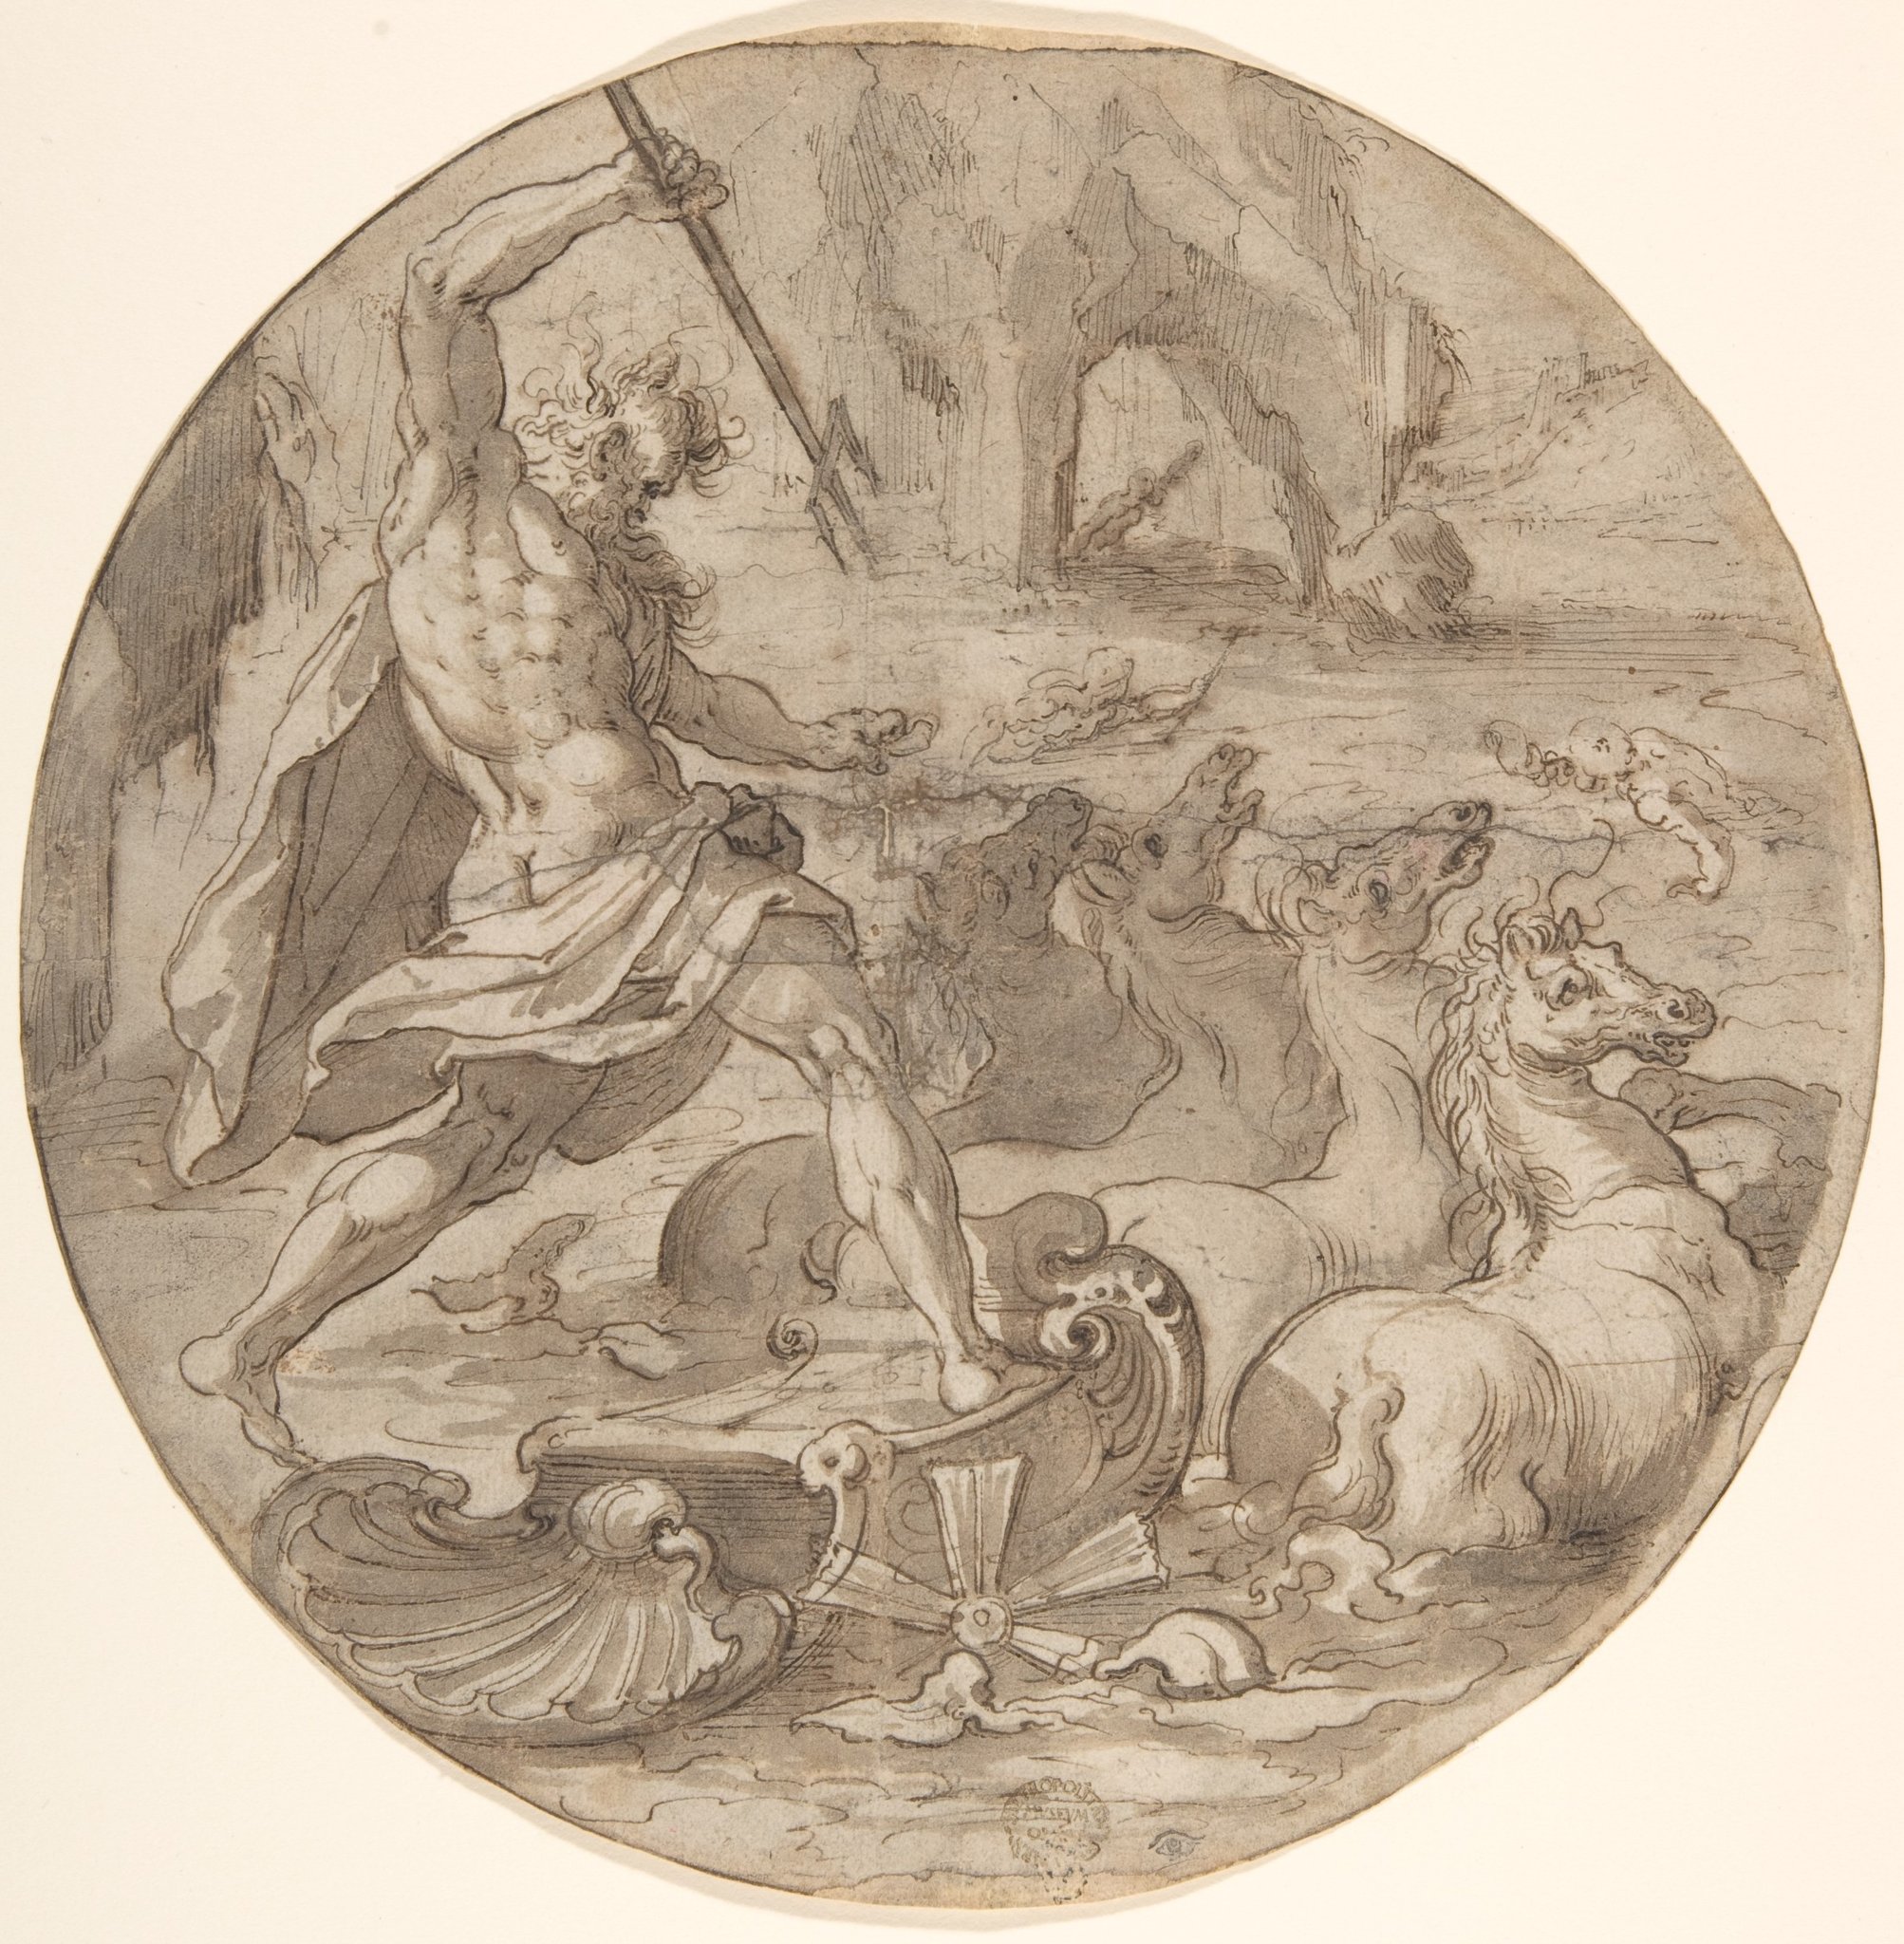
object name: drawing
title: Neptune in his Chariot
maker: pieter de jode (i)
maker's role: artist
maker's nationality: netherlandish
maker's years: 1570-1634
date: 1567-1666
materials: chalk, ink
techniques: pen, wash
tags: neptune,horses,chariots